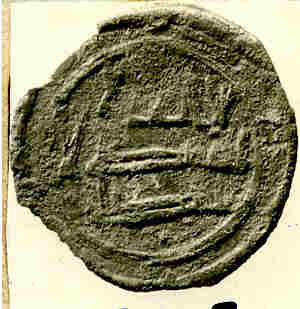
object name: coin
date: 701-800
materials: copper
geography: iran